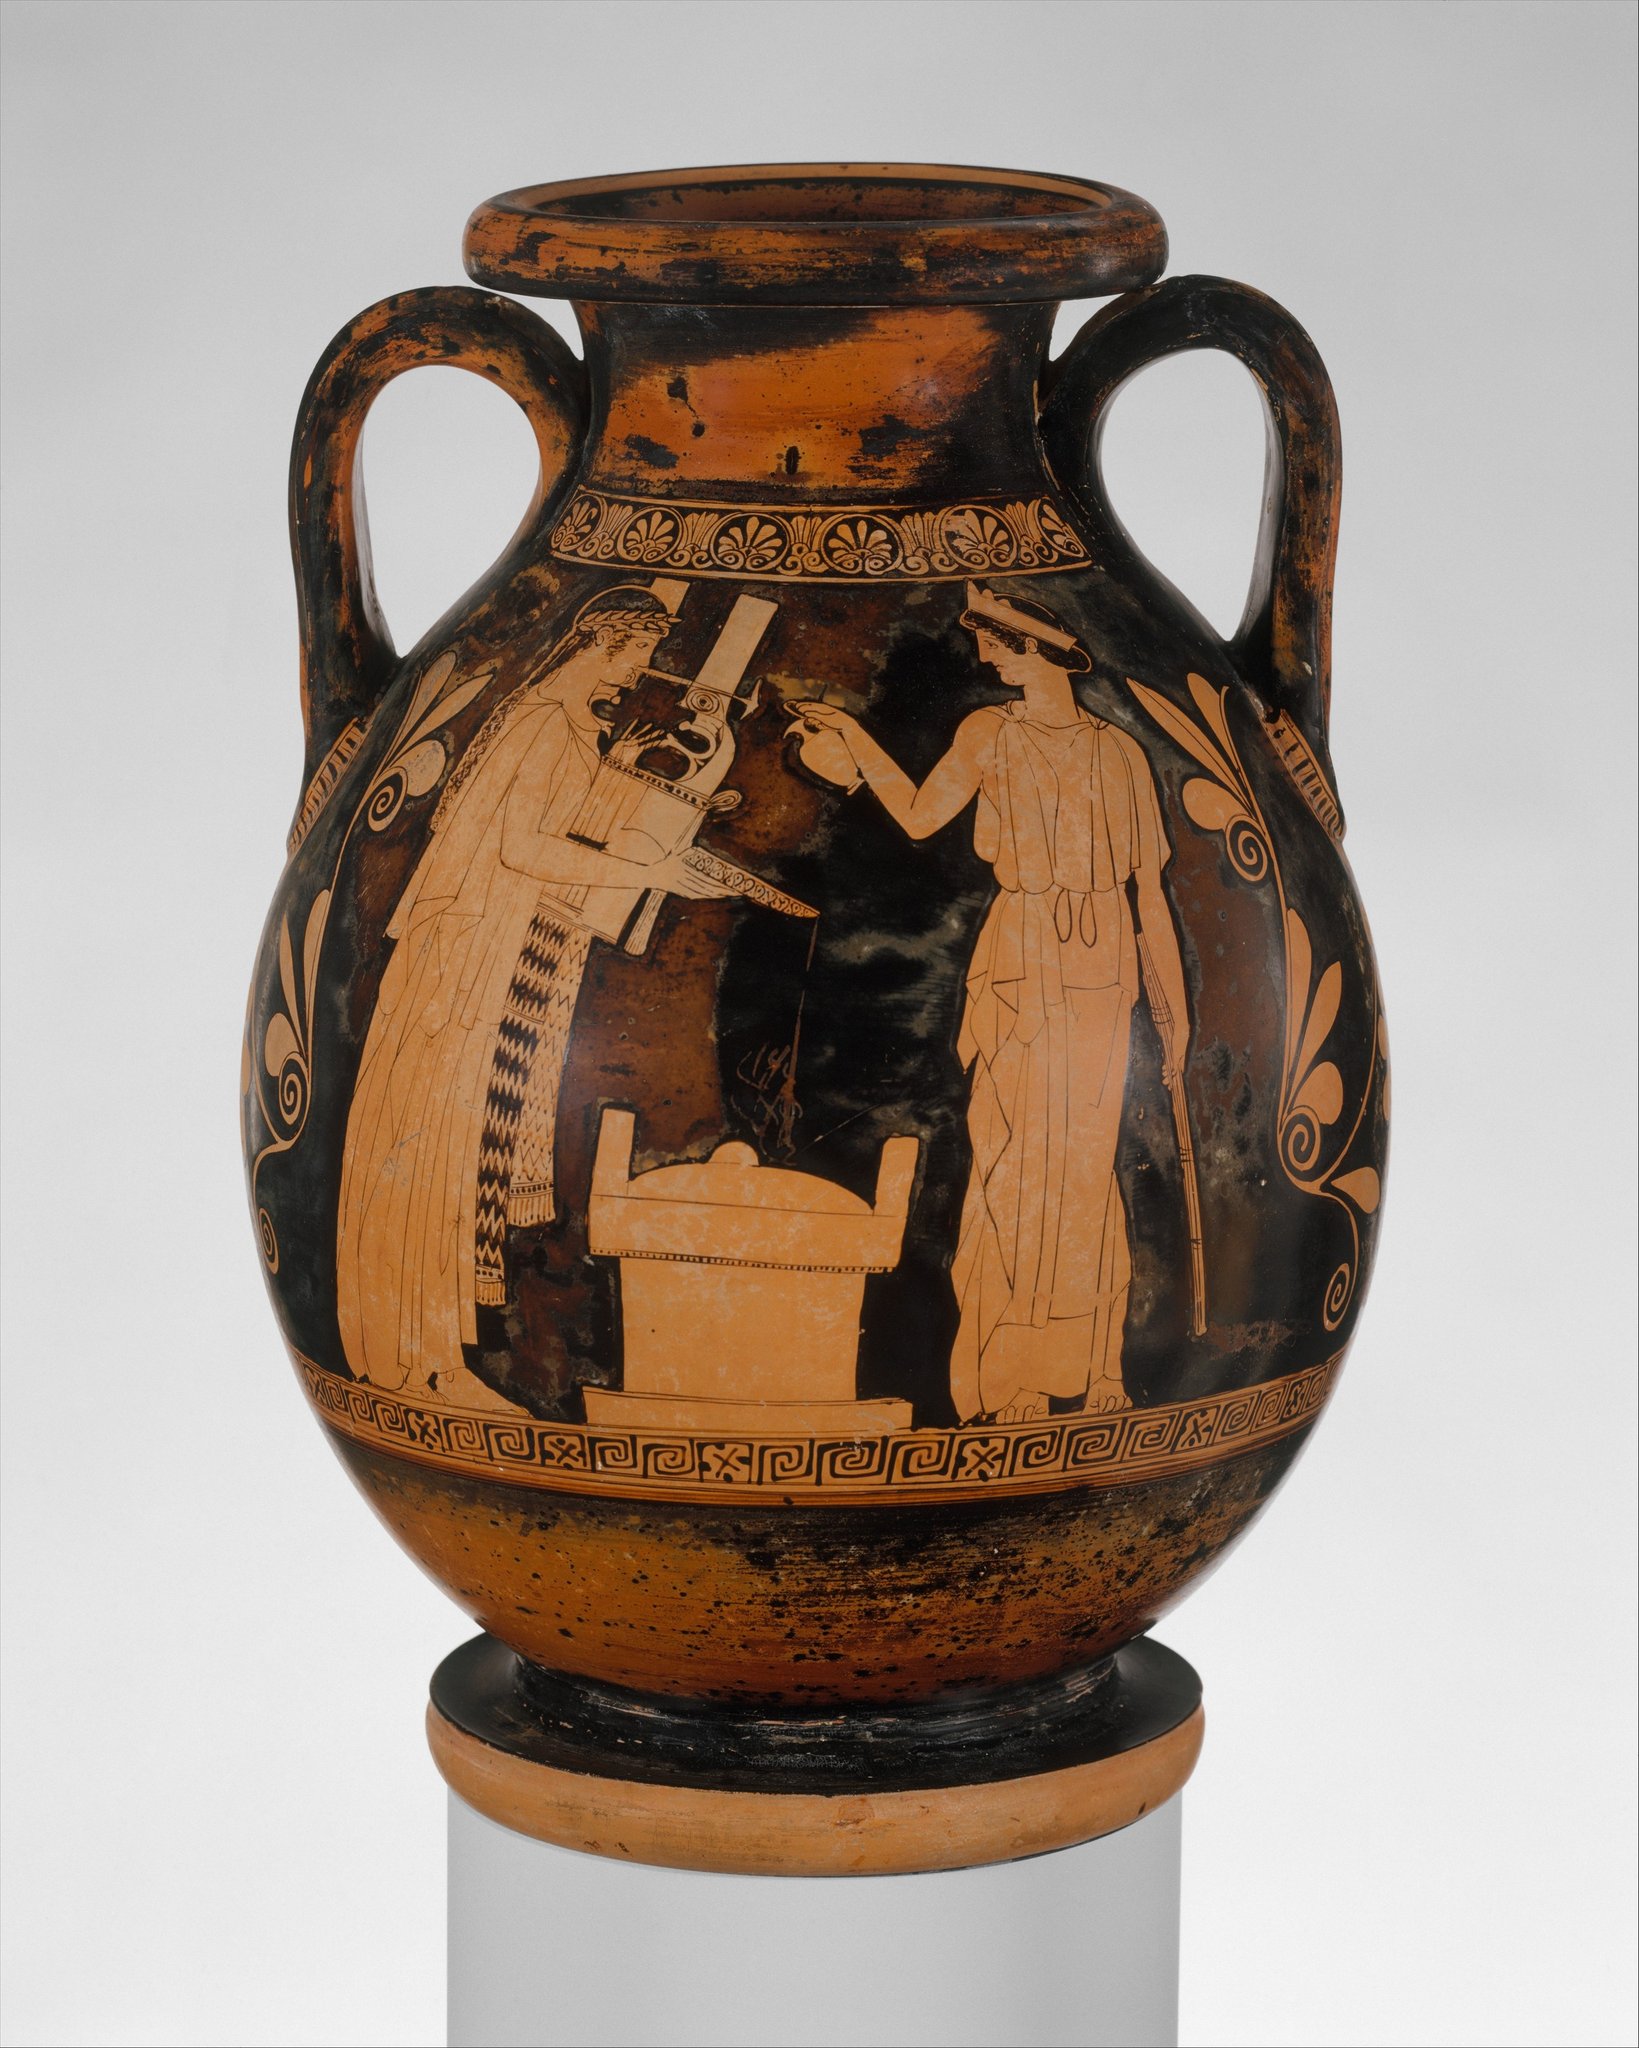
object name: pelike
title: Terracotta pelike (jar)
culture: greek, attic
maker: chicago painter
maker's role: artist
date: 467-435 BCE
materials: terracotta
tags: altars,women,apollo,artemis